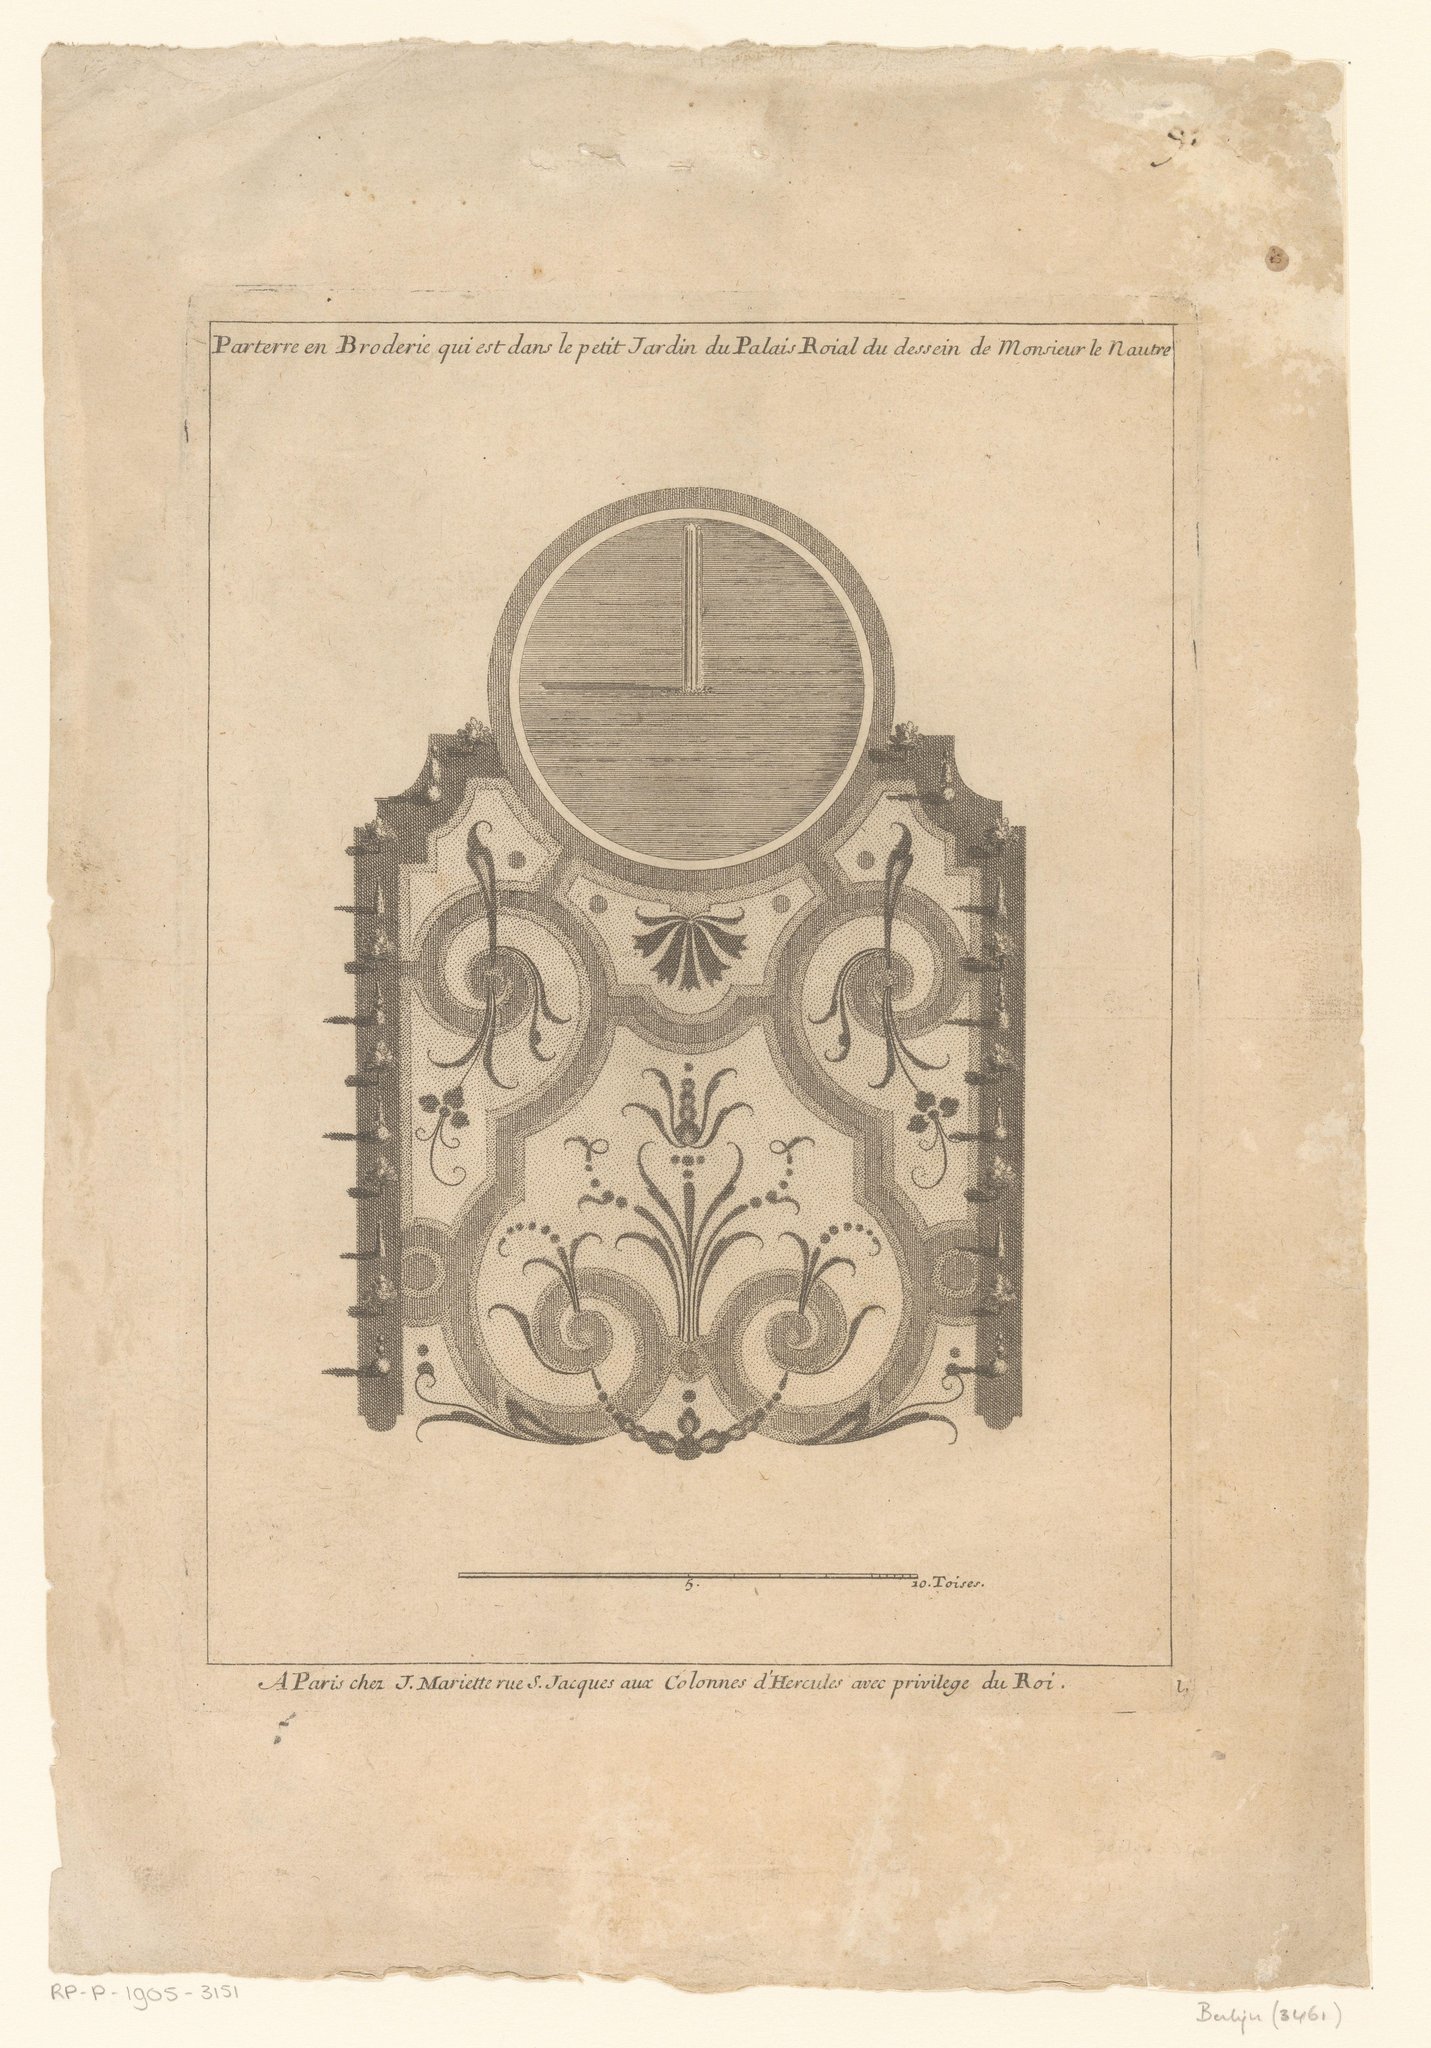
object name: print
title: Parterre met fontein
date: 1691-1742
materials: paper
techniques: etching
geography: paris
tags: plan, map of garden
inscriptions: collector's mark: Lugt 2228, inscription: ‘2a / 3-12-'76’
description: Een parterre met aan de bovenzijde een ronde fontein. Links en rechts bomenlanen.